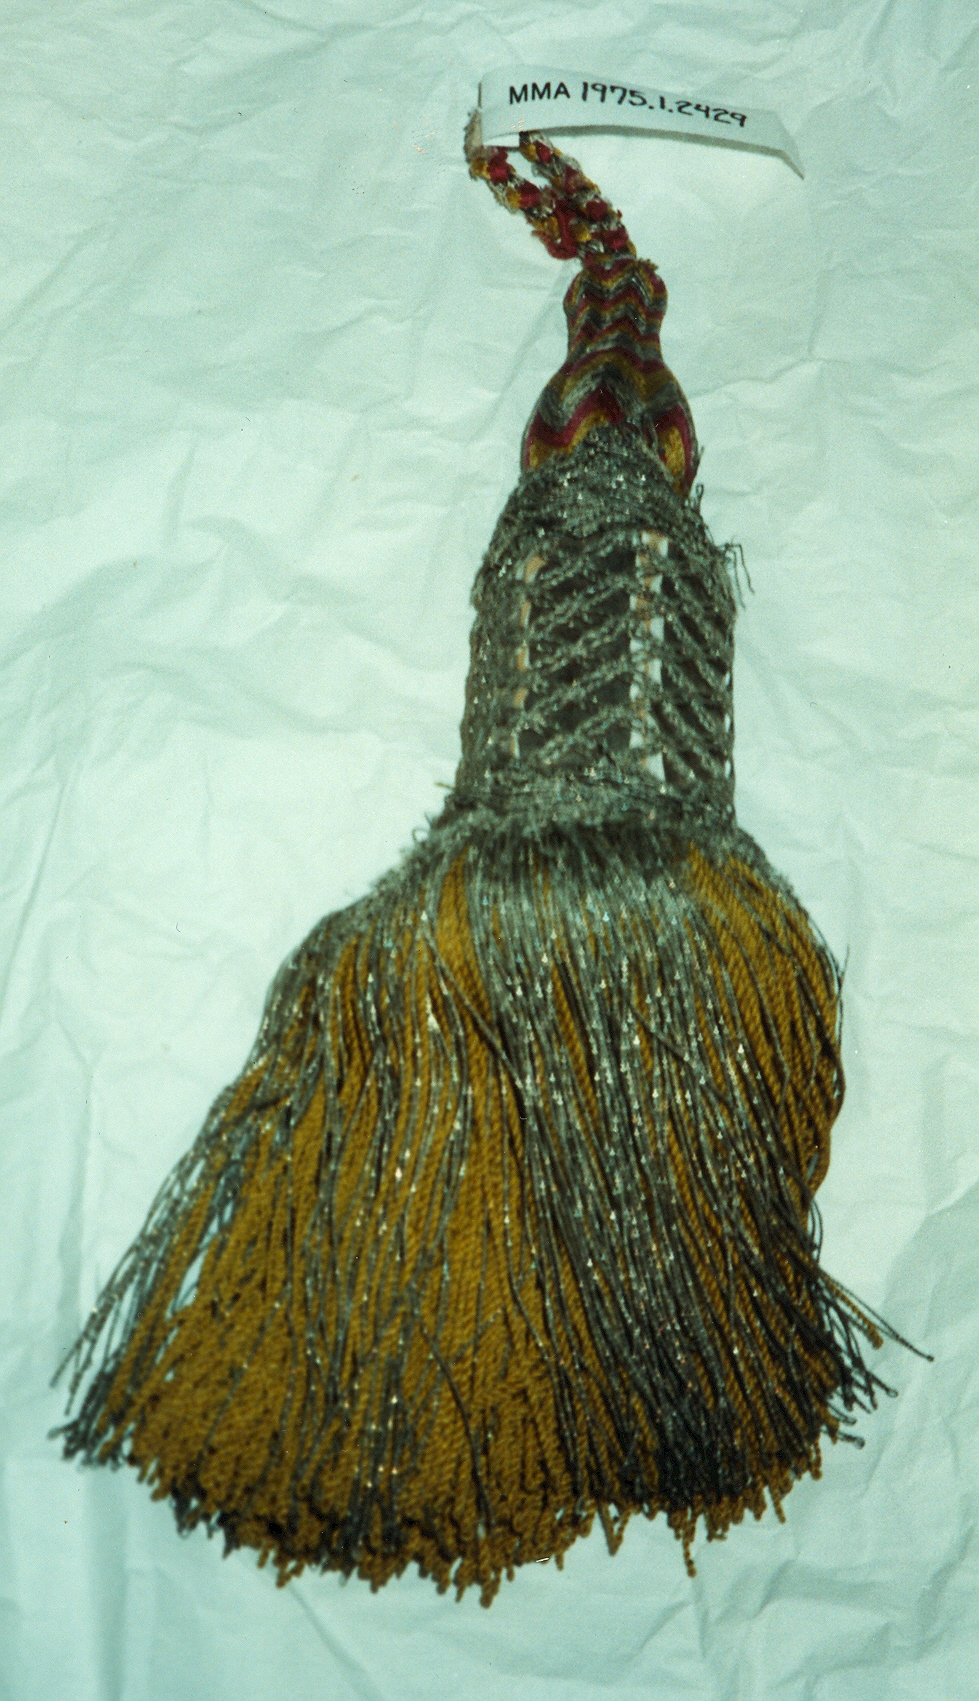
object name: tassel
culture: european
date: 1601-1900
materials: cotton, metal, mica